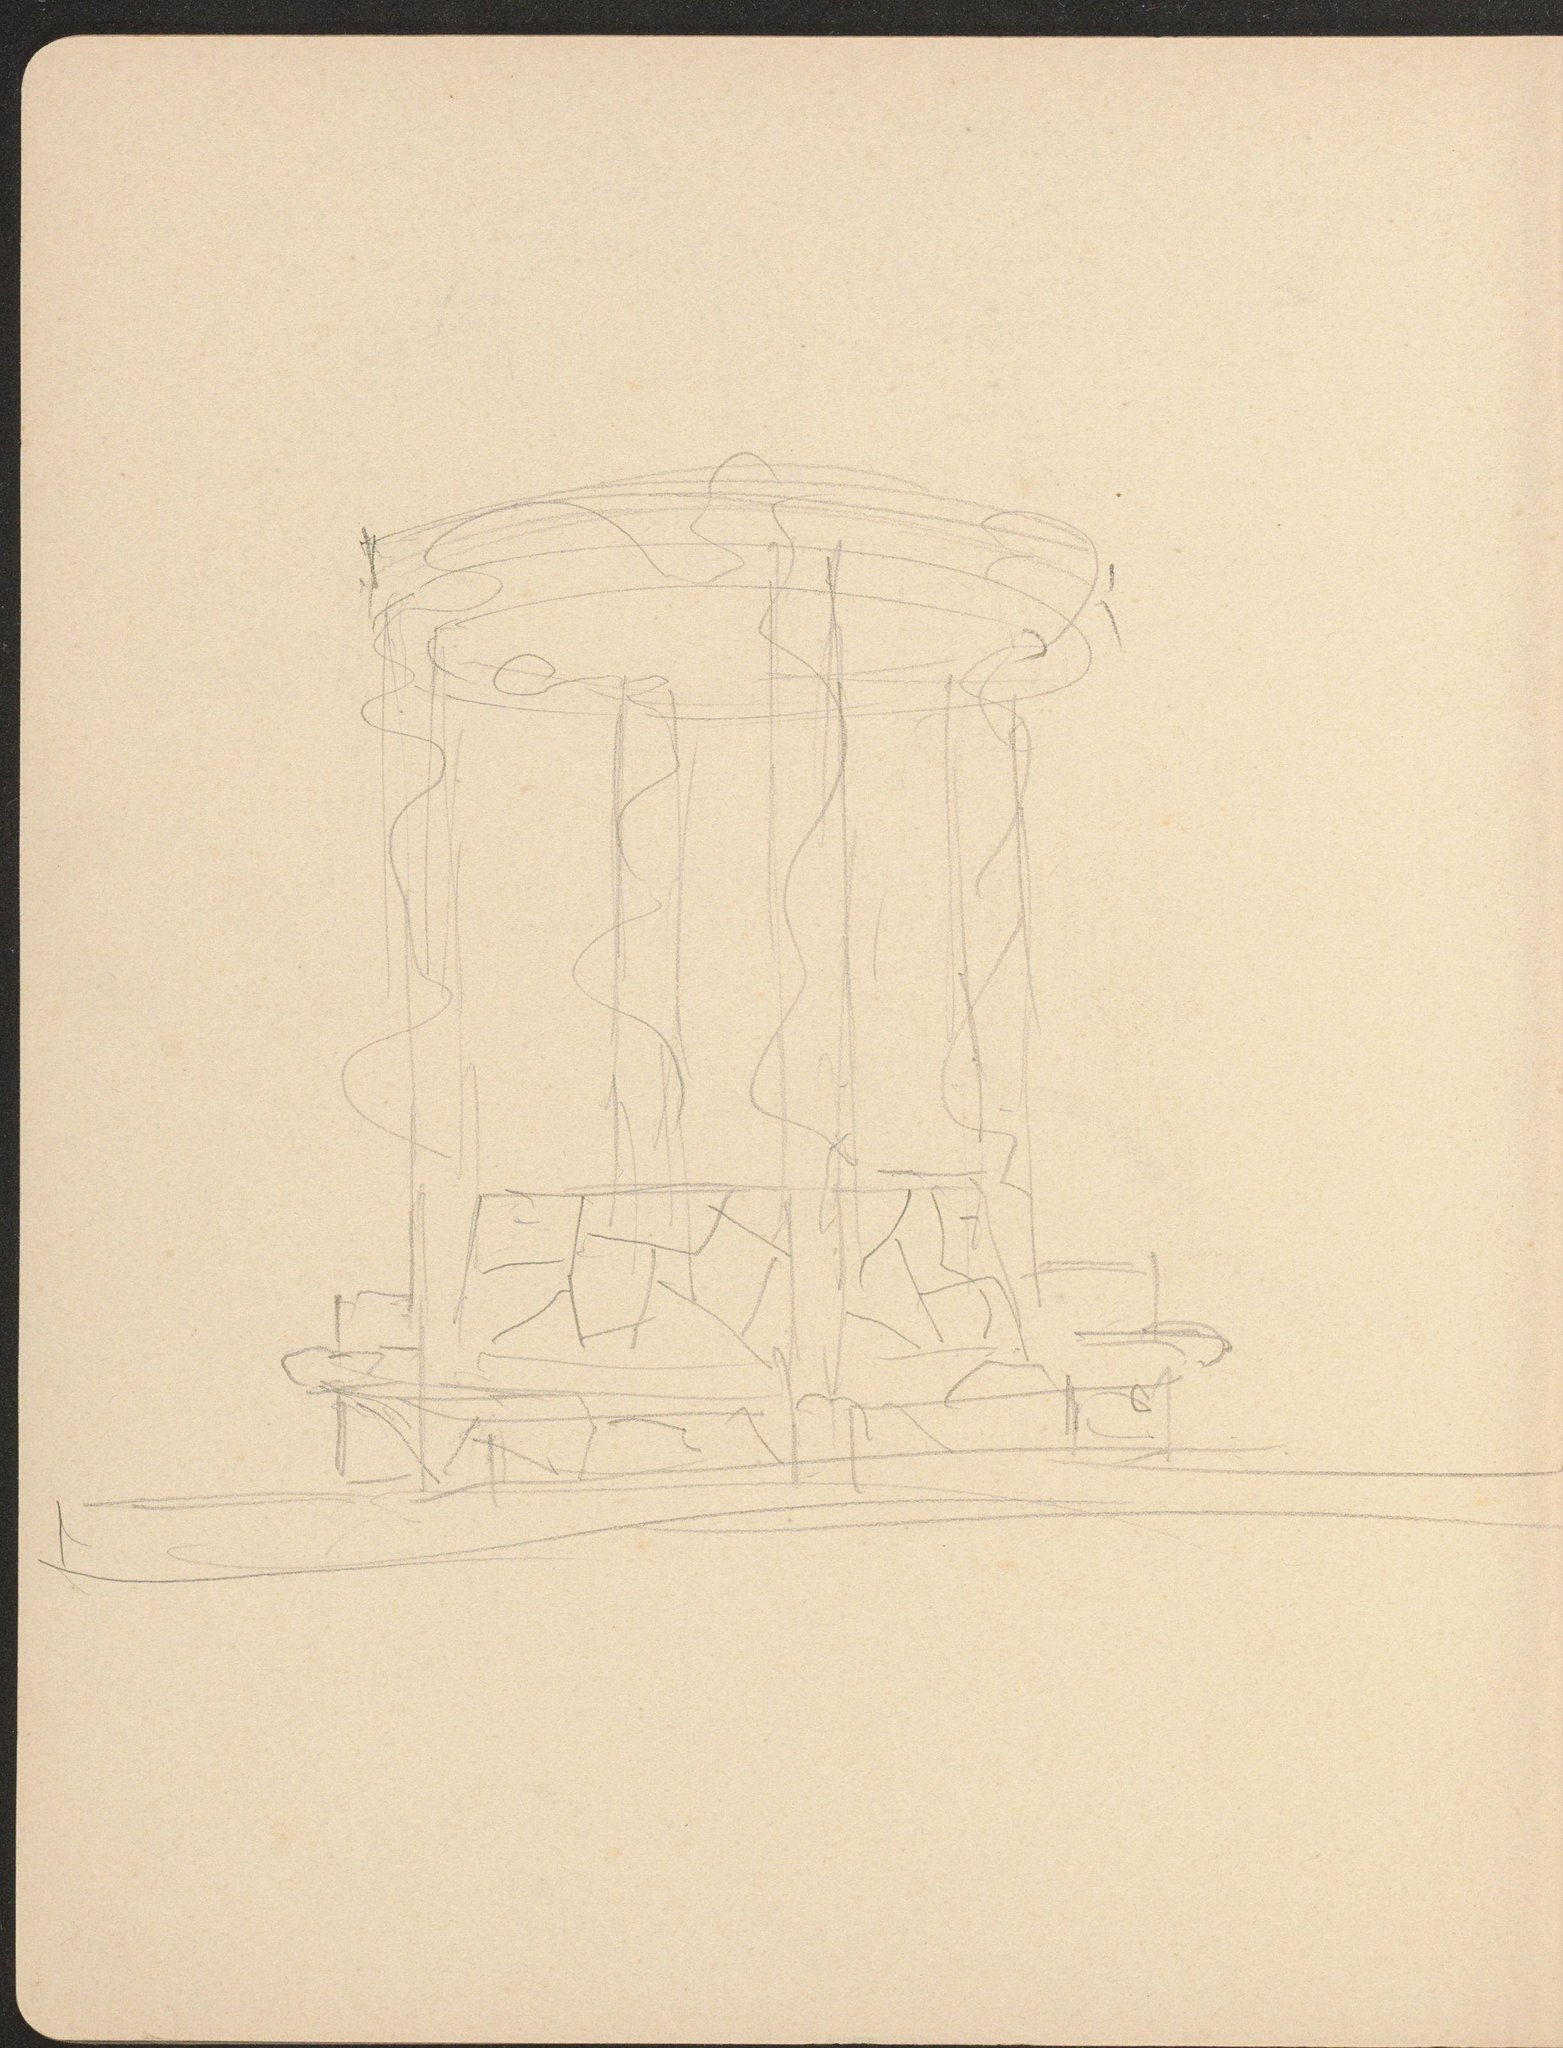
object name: sketchbook leaf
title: Ontwerp voor een monumentale bank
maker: carel adolph lion cachet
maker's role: draughtsman, print maker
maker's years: 1864-1945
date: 1930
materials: paper, pencil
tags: bench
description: Blad 2 verso uit een schetsboek met 9 bladen.